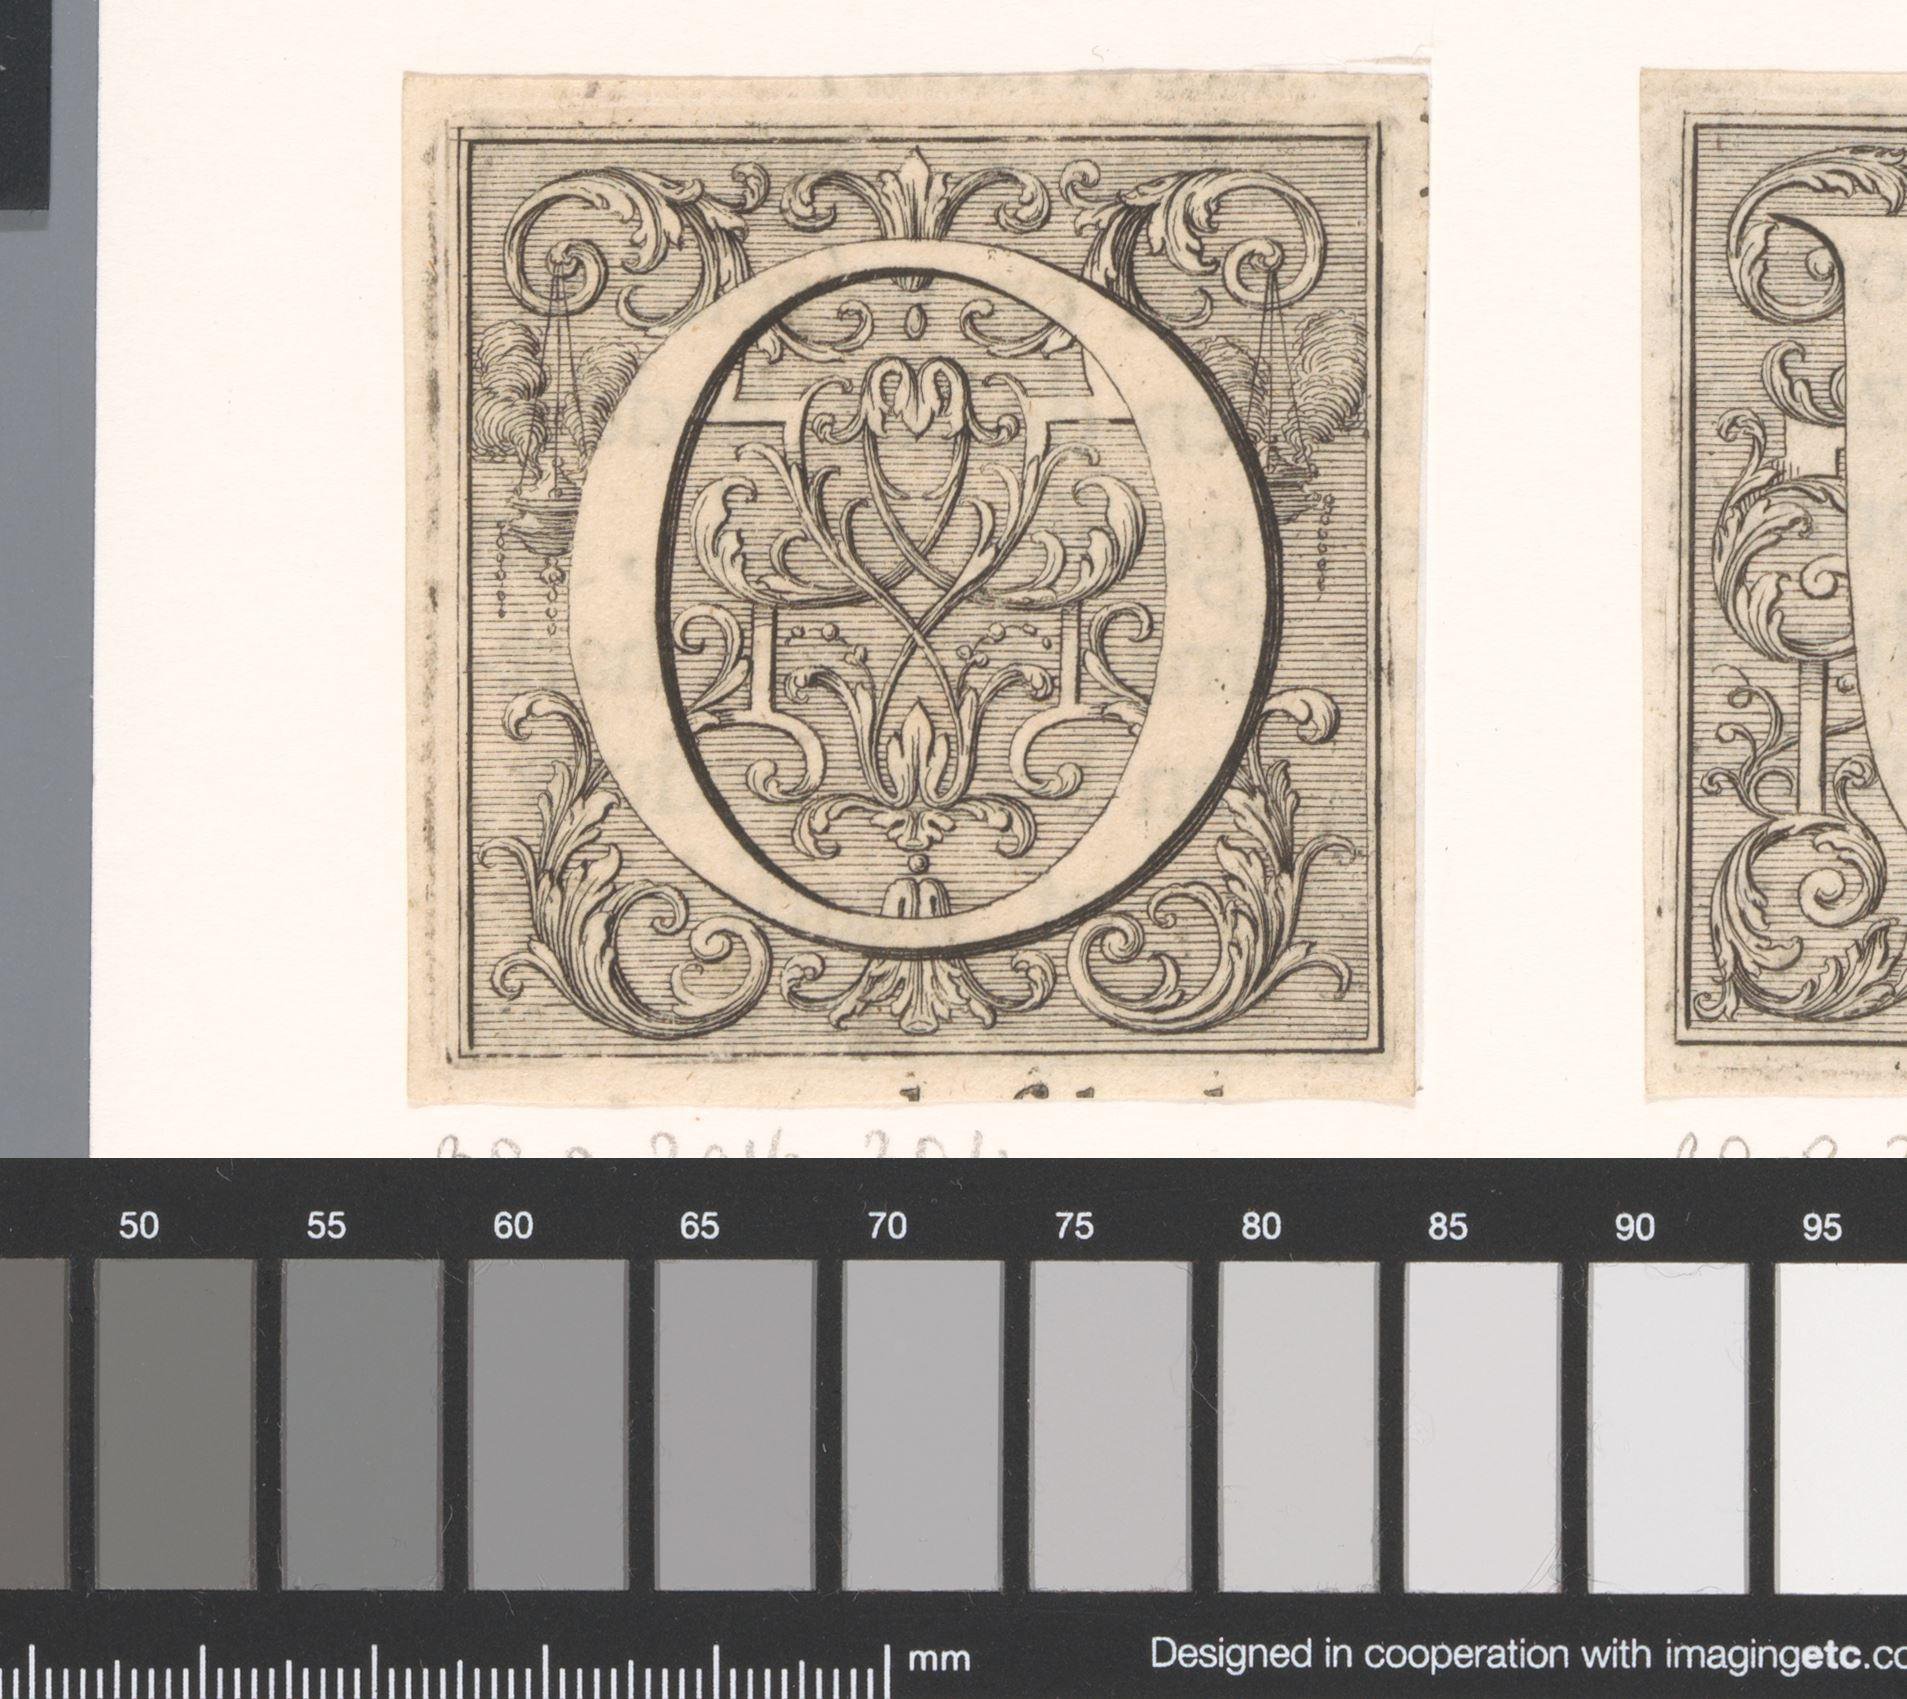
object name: book illustration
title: Letter O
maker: Anonymous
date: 1700-1799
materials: paper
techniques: etching, letterpress printing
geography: netherlands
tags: fancy letters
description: Letter O tegen een achtergrond met vlechtwerk.